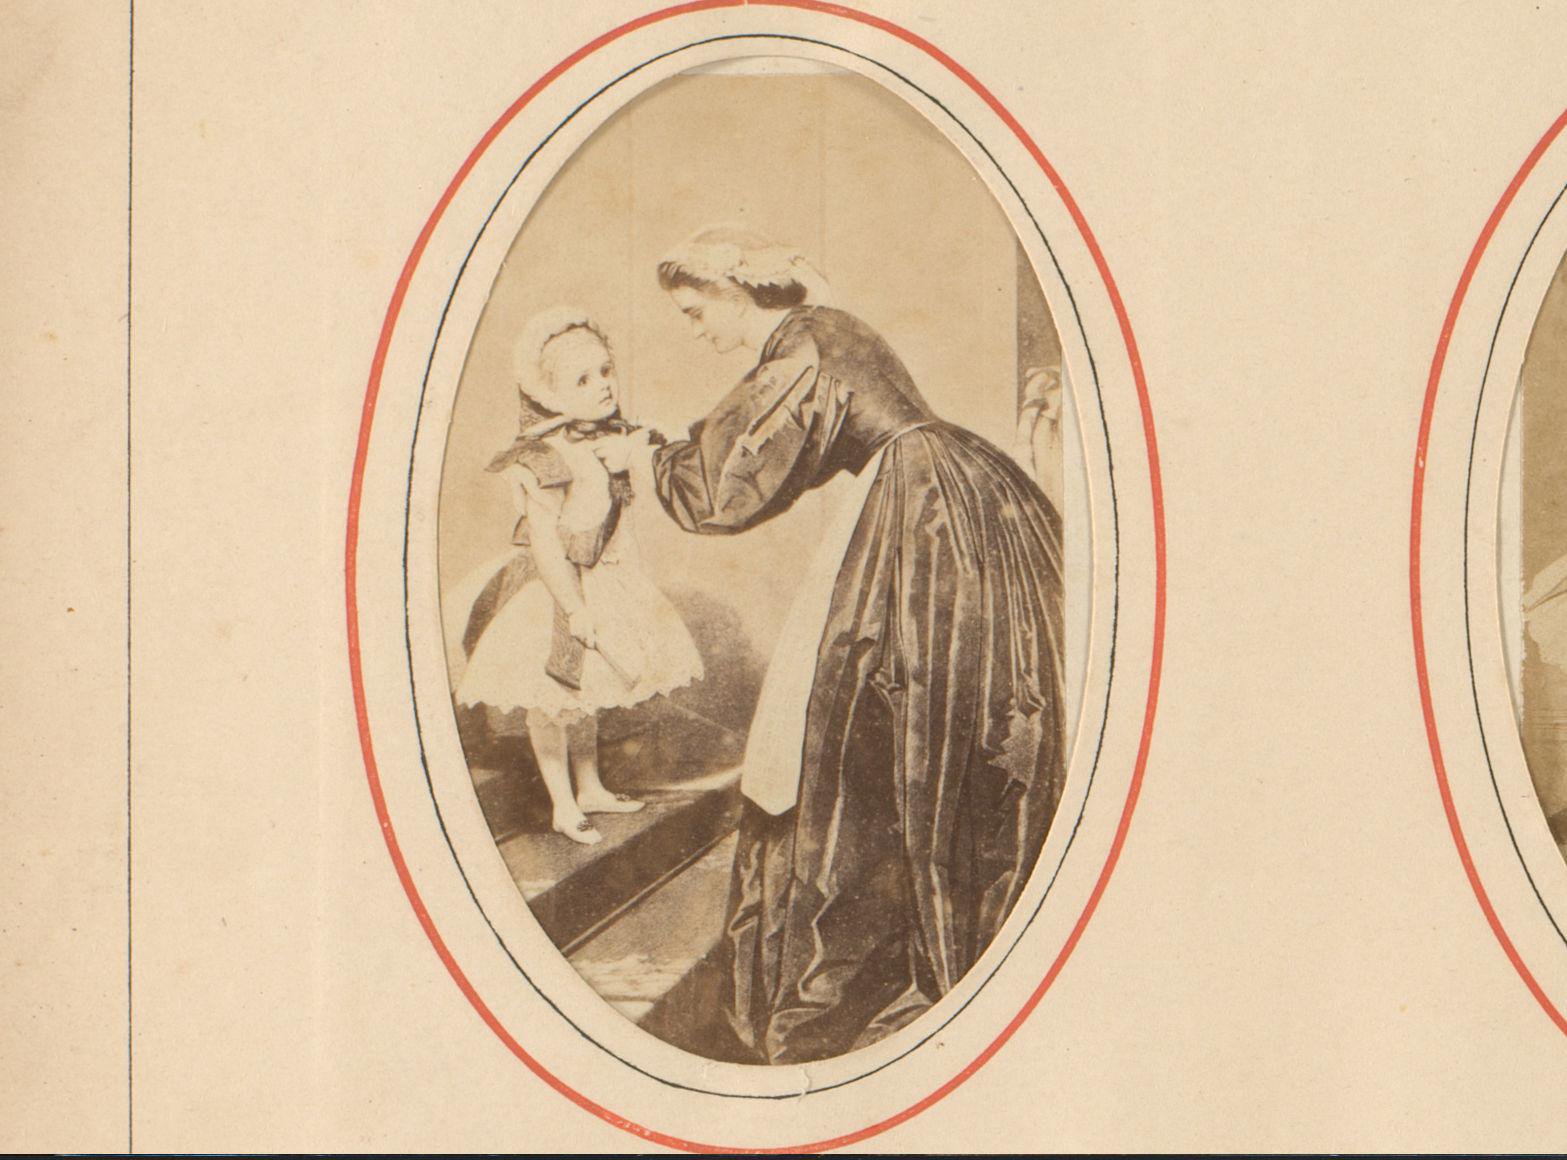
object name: reproduction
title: Fotoreproductie van een schilderij van Miss Lily met een dienstmeid, door James Hayllar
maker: Anonymous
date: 1870-1890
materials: cardboard, paper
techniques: albumen print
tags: girl (child between toddler and youth)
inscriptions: number: ‘No 404.’